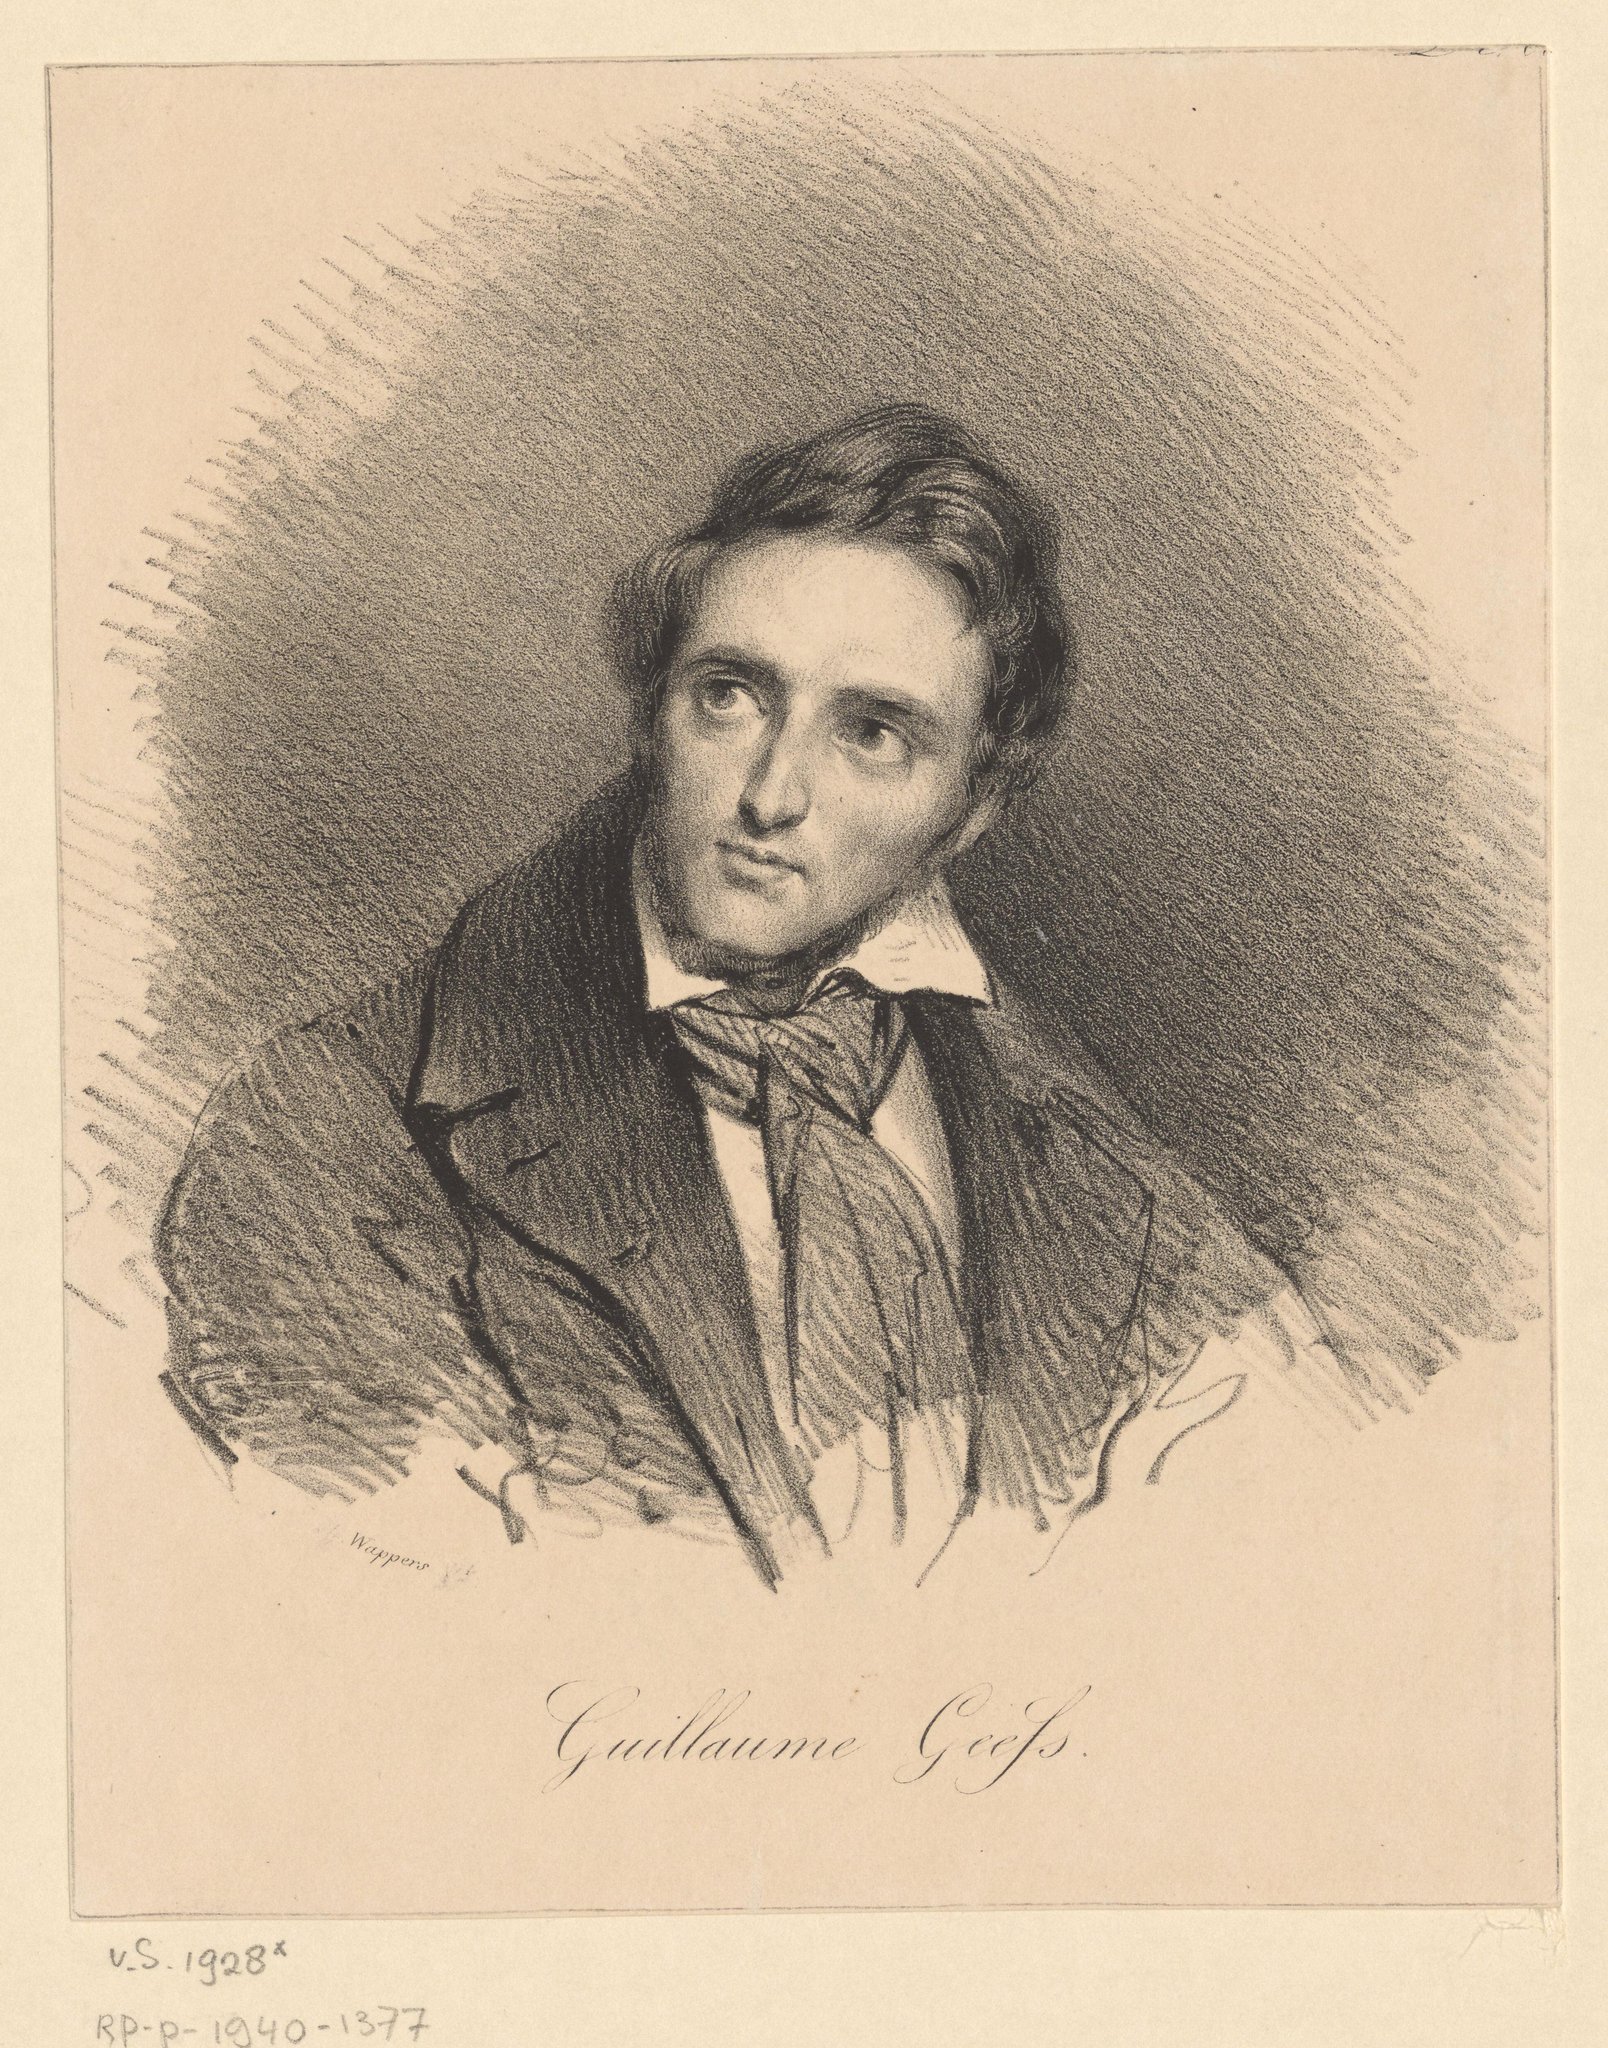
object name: print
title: Portret van Willem Geefs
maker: gustave wappers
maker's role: draughtsman, painter, print maker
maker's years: 1803-1874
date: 1820-1874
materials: paper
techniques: lithograph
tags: antwerp, willem geefs, portrait, self-portrait of sculptor, historical persons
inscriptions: collector's mark: Lugt 2760, collector's mark: Lugt 2166